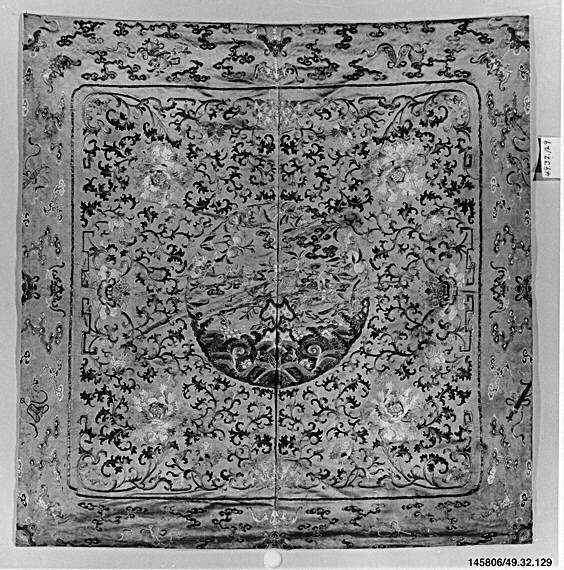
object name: furniture cover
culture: chinese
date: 1736-1795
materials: metal thread, silk